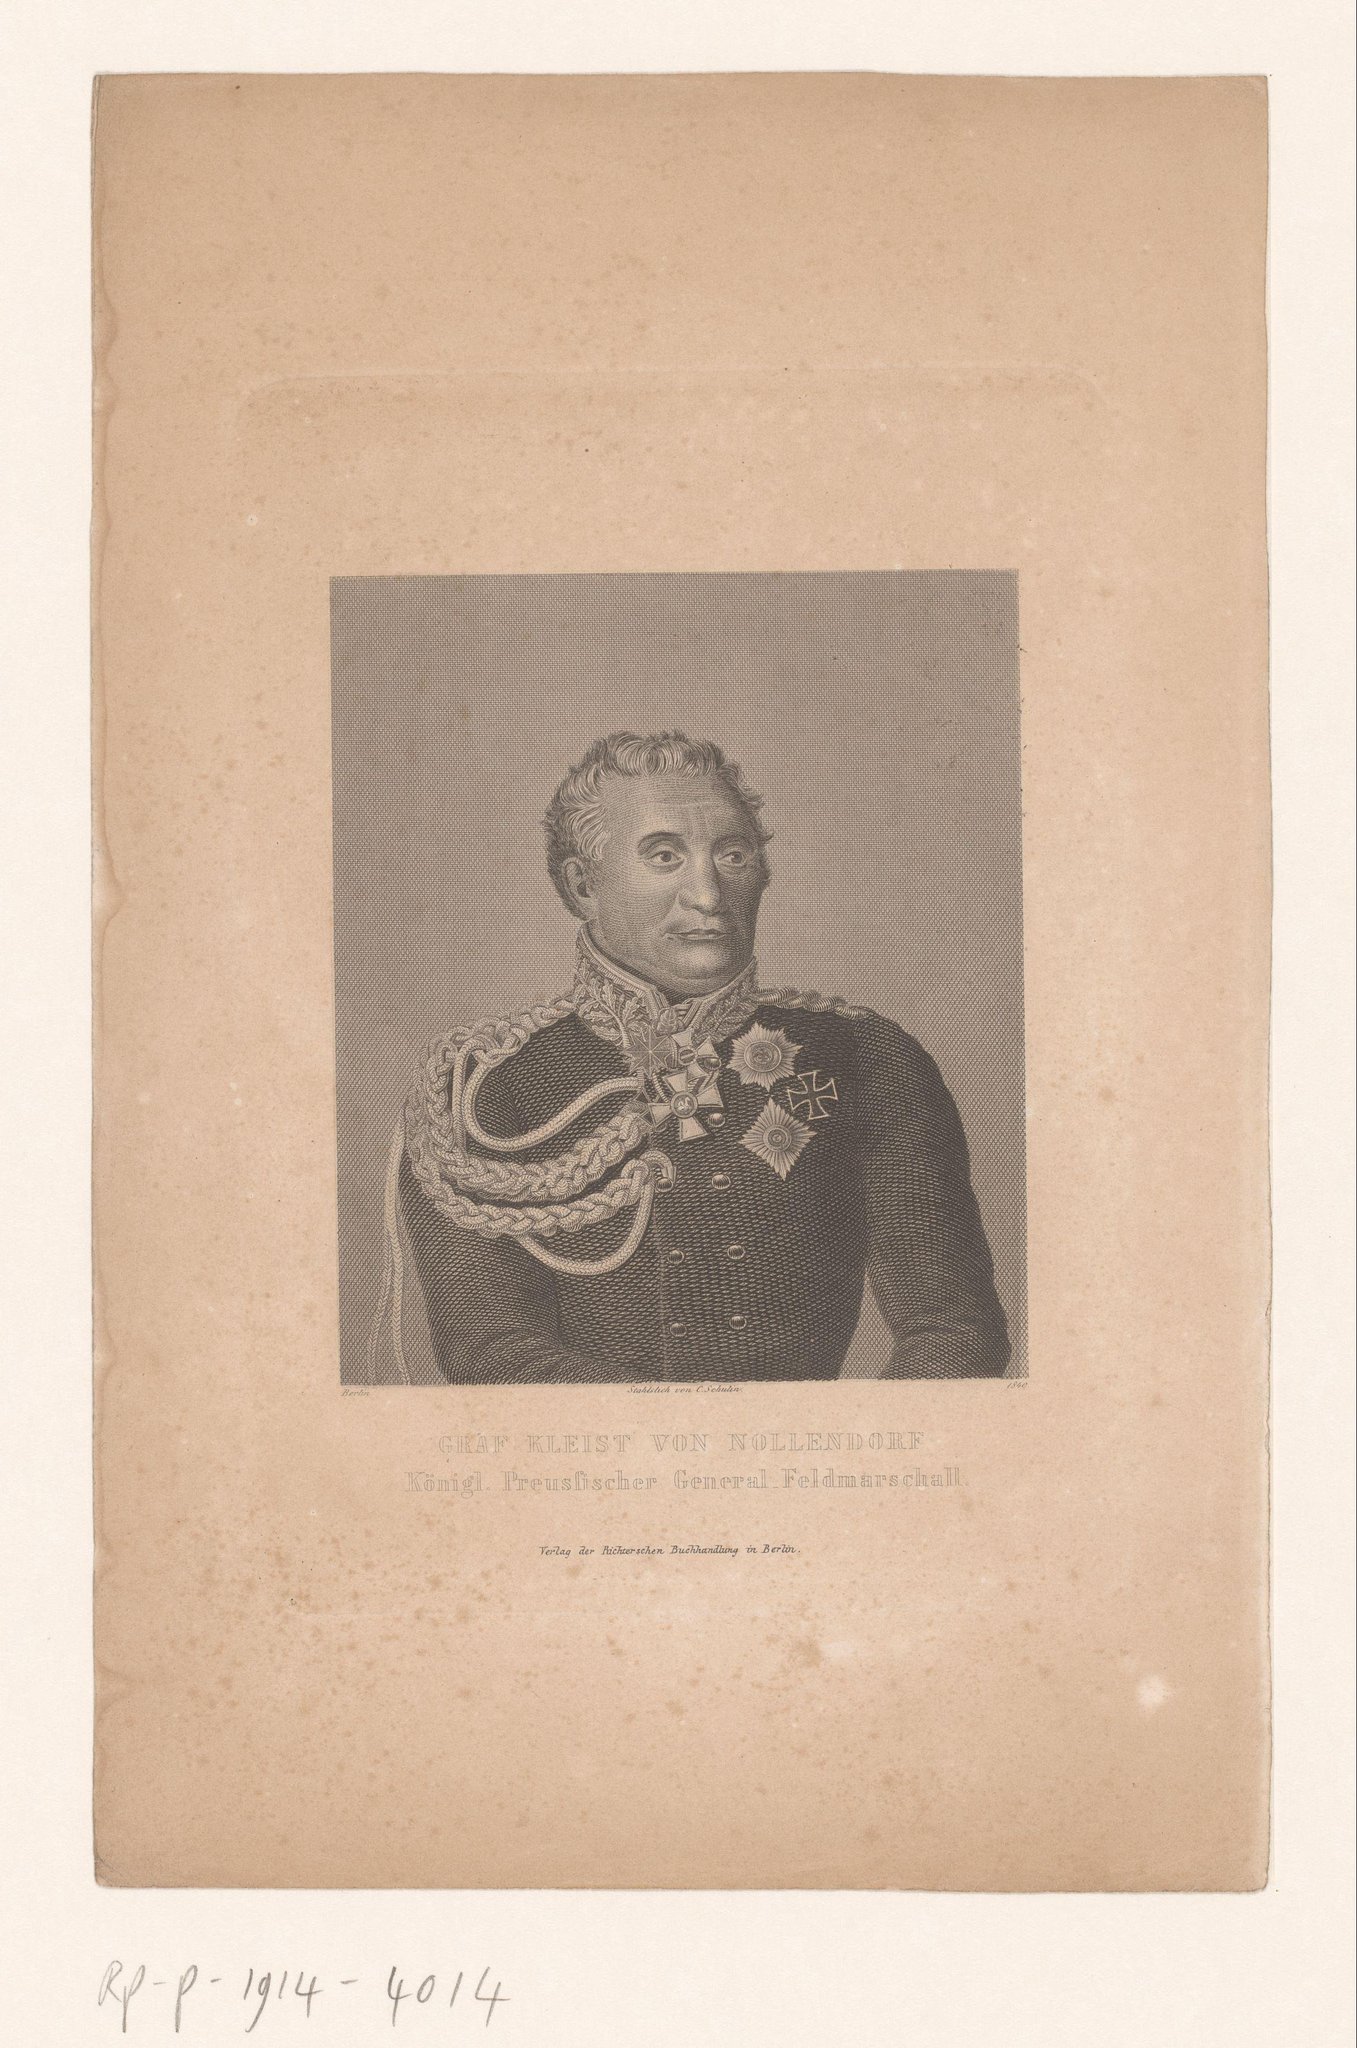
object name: print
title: Portret van Friedrich Heinrich Ferdinand Emil Kleist von Nollendorf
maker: carl schulin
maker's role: print maker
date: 1840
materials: paper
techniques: engraving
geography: berlin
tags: berlin, historical persons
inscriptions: collector's mark: Lugt 2228